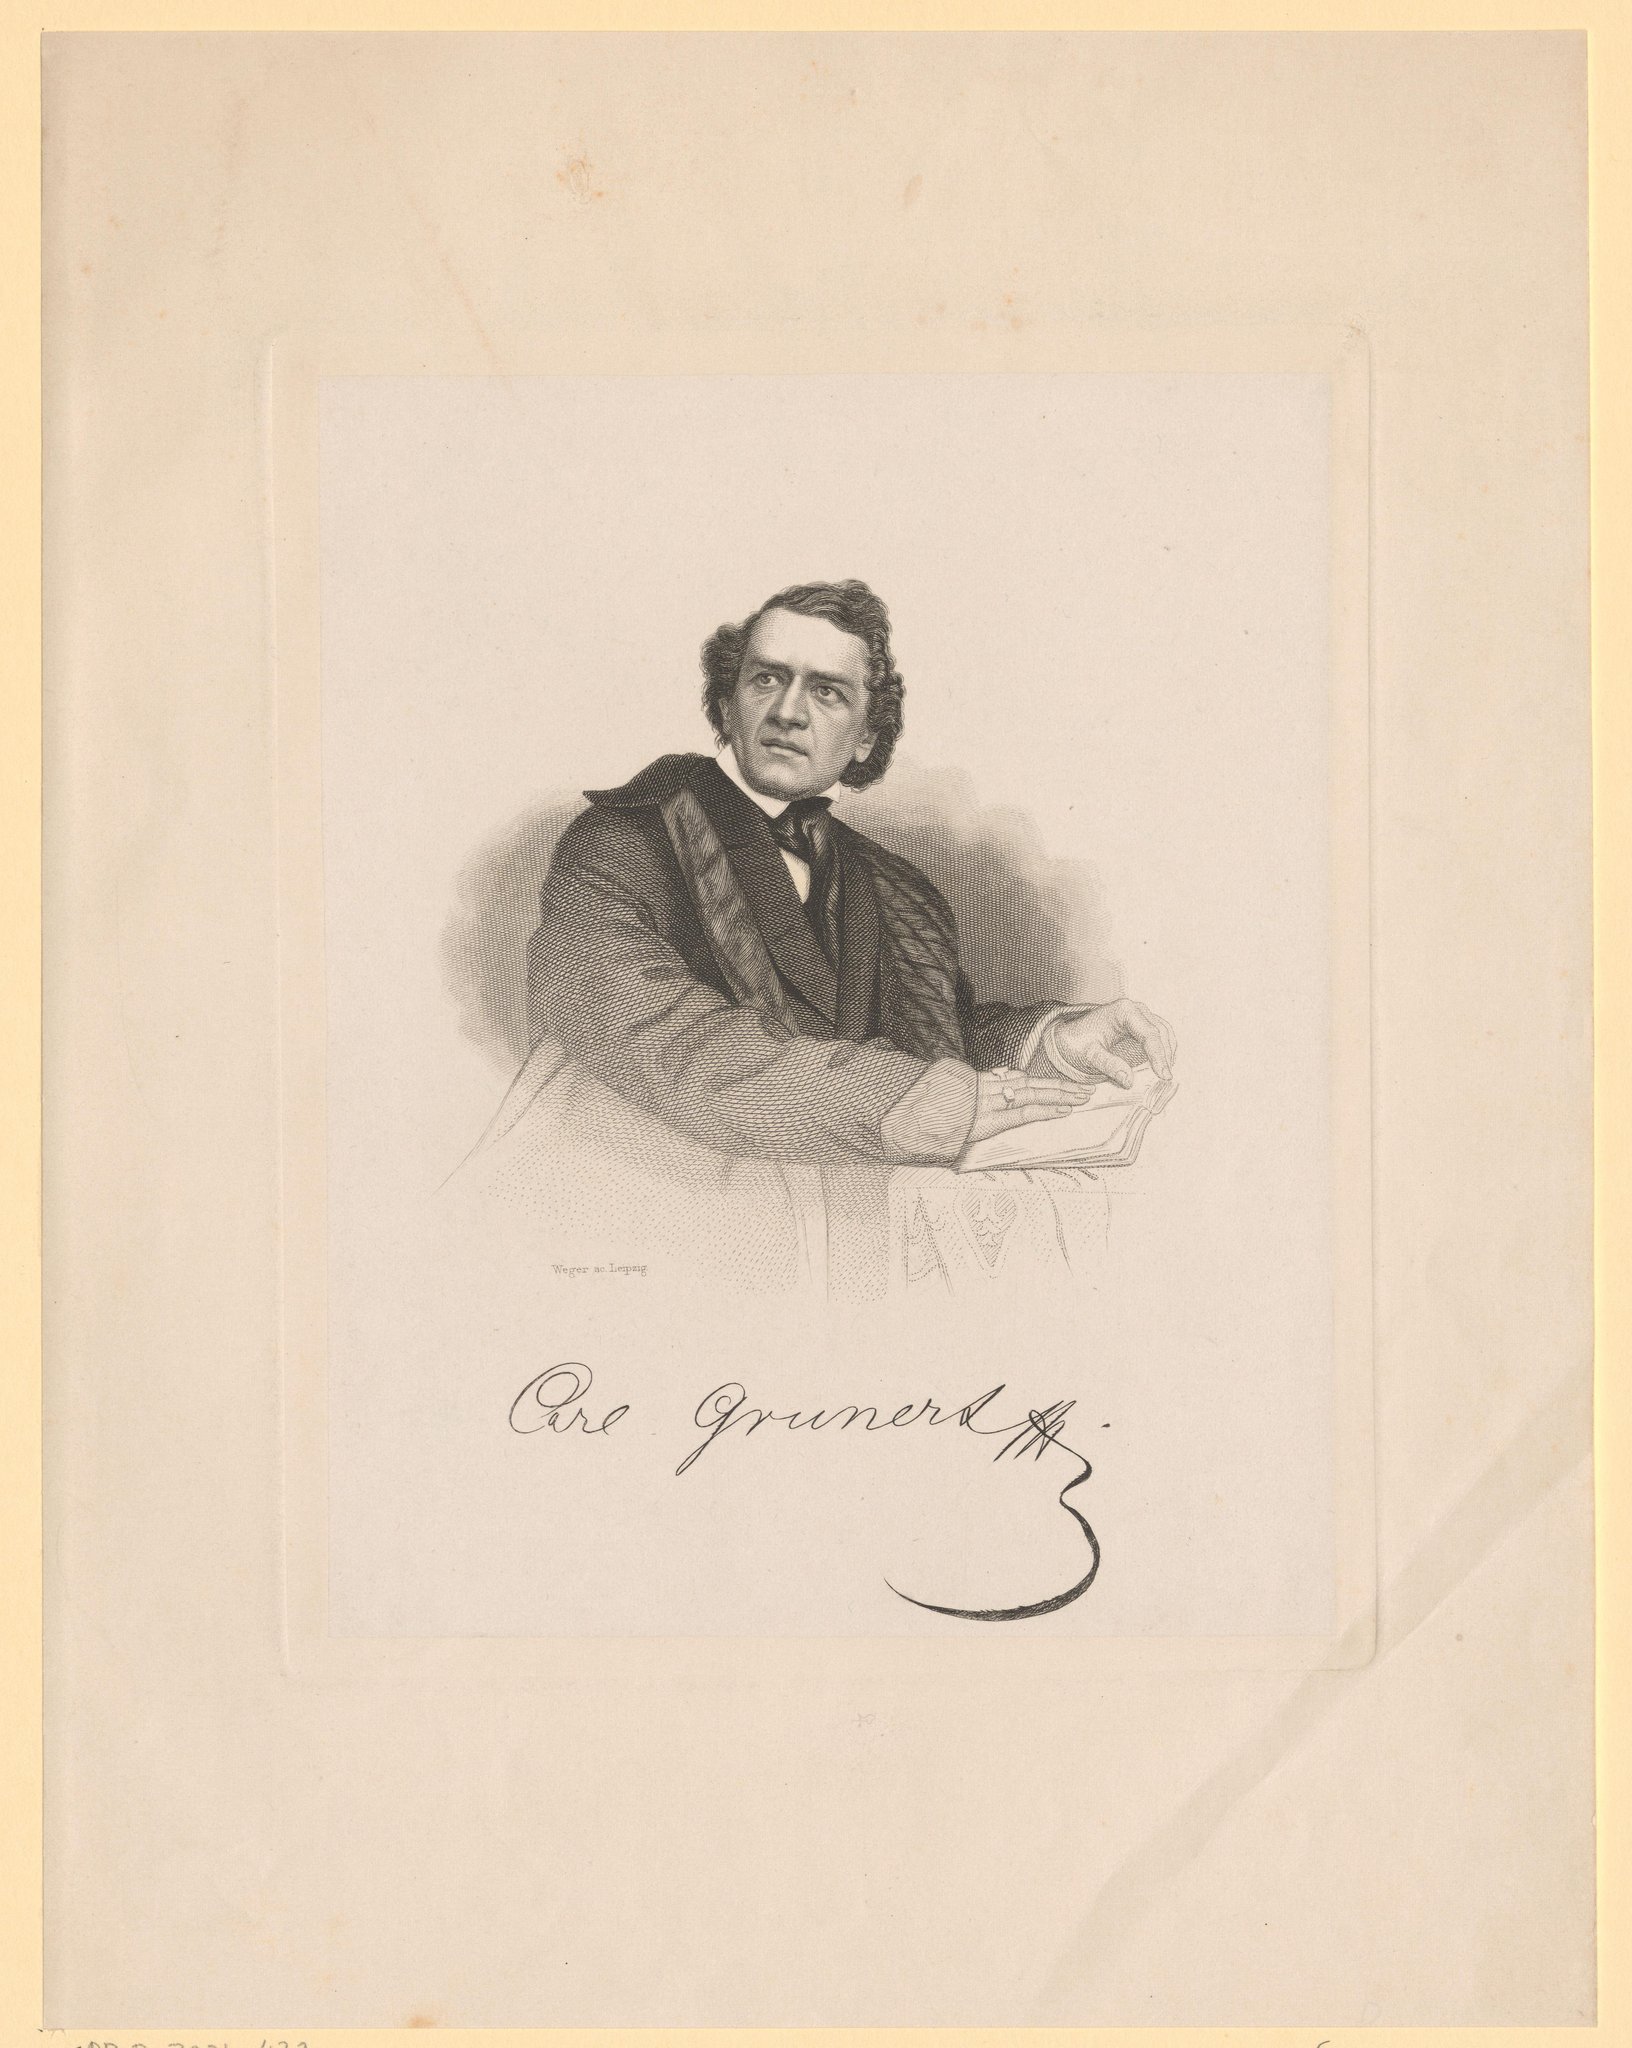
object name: print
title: Portret van Carl Grunert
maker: august weger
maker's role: print maker, printer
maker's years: 1823-1892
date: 1833-1892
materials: paper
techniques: engraving, etching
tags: historical persons, portrait of actor, actress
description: Een facsimile signatuur in de ondermarge.